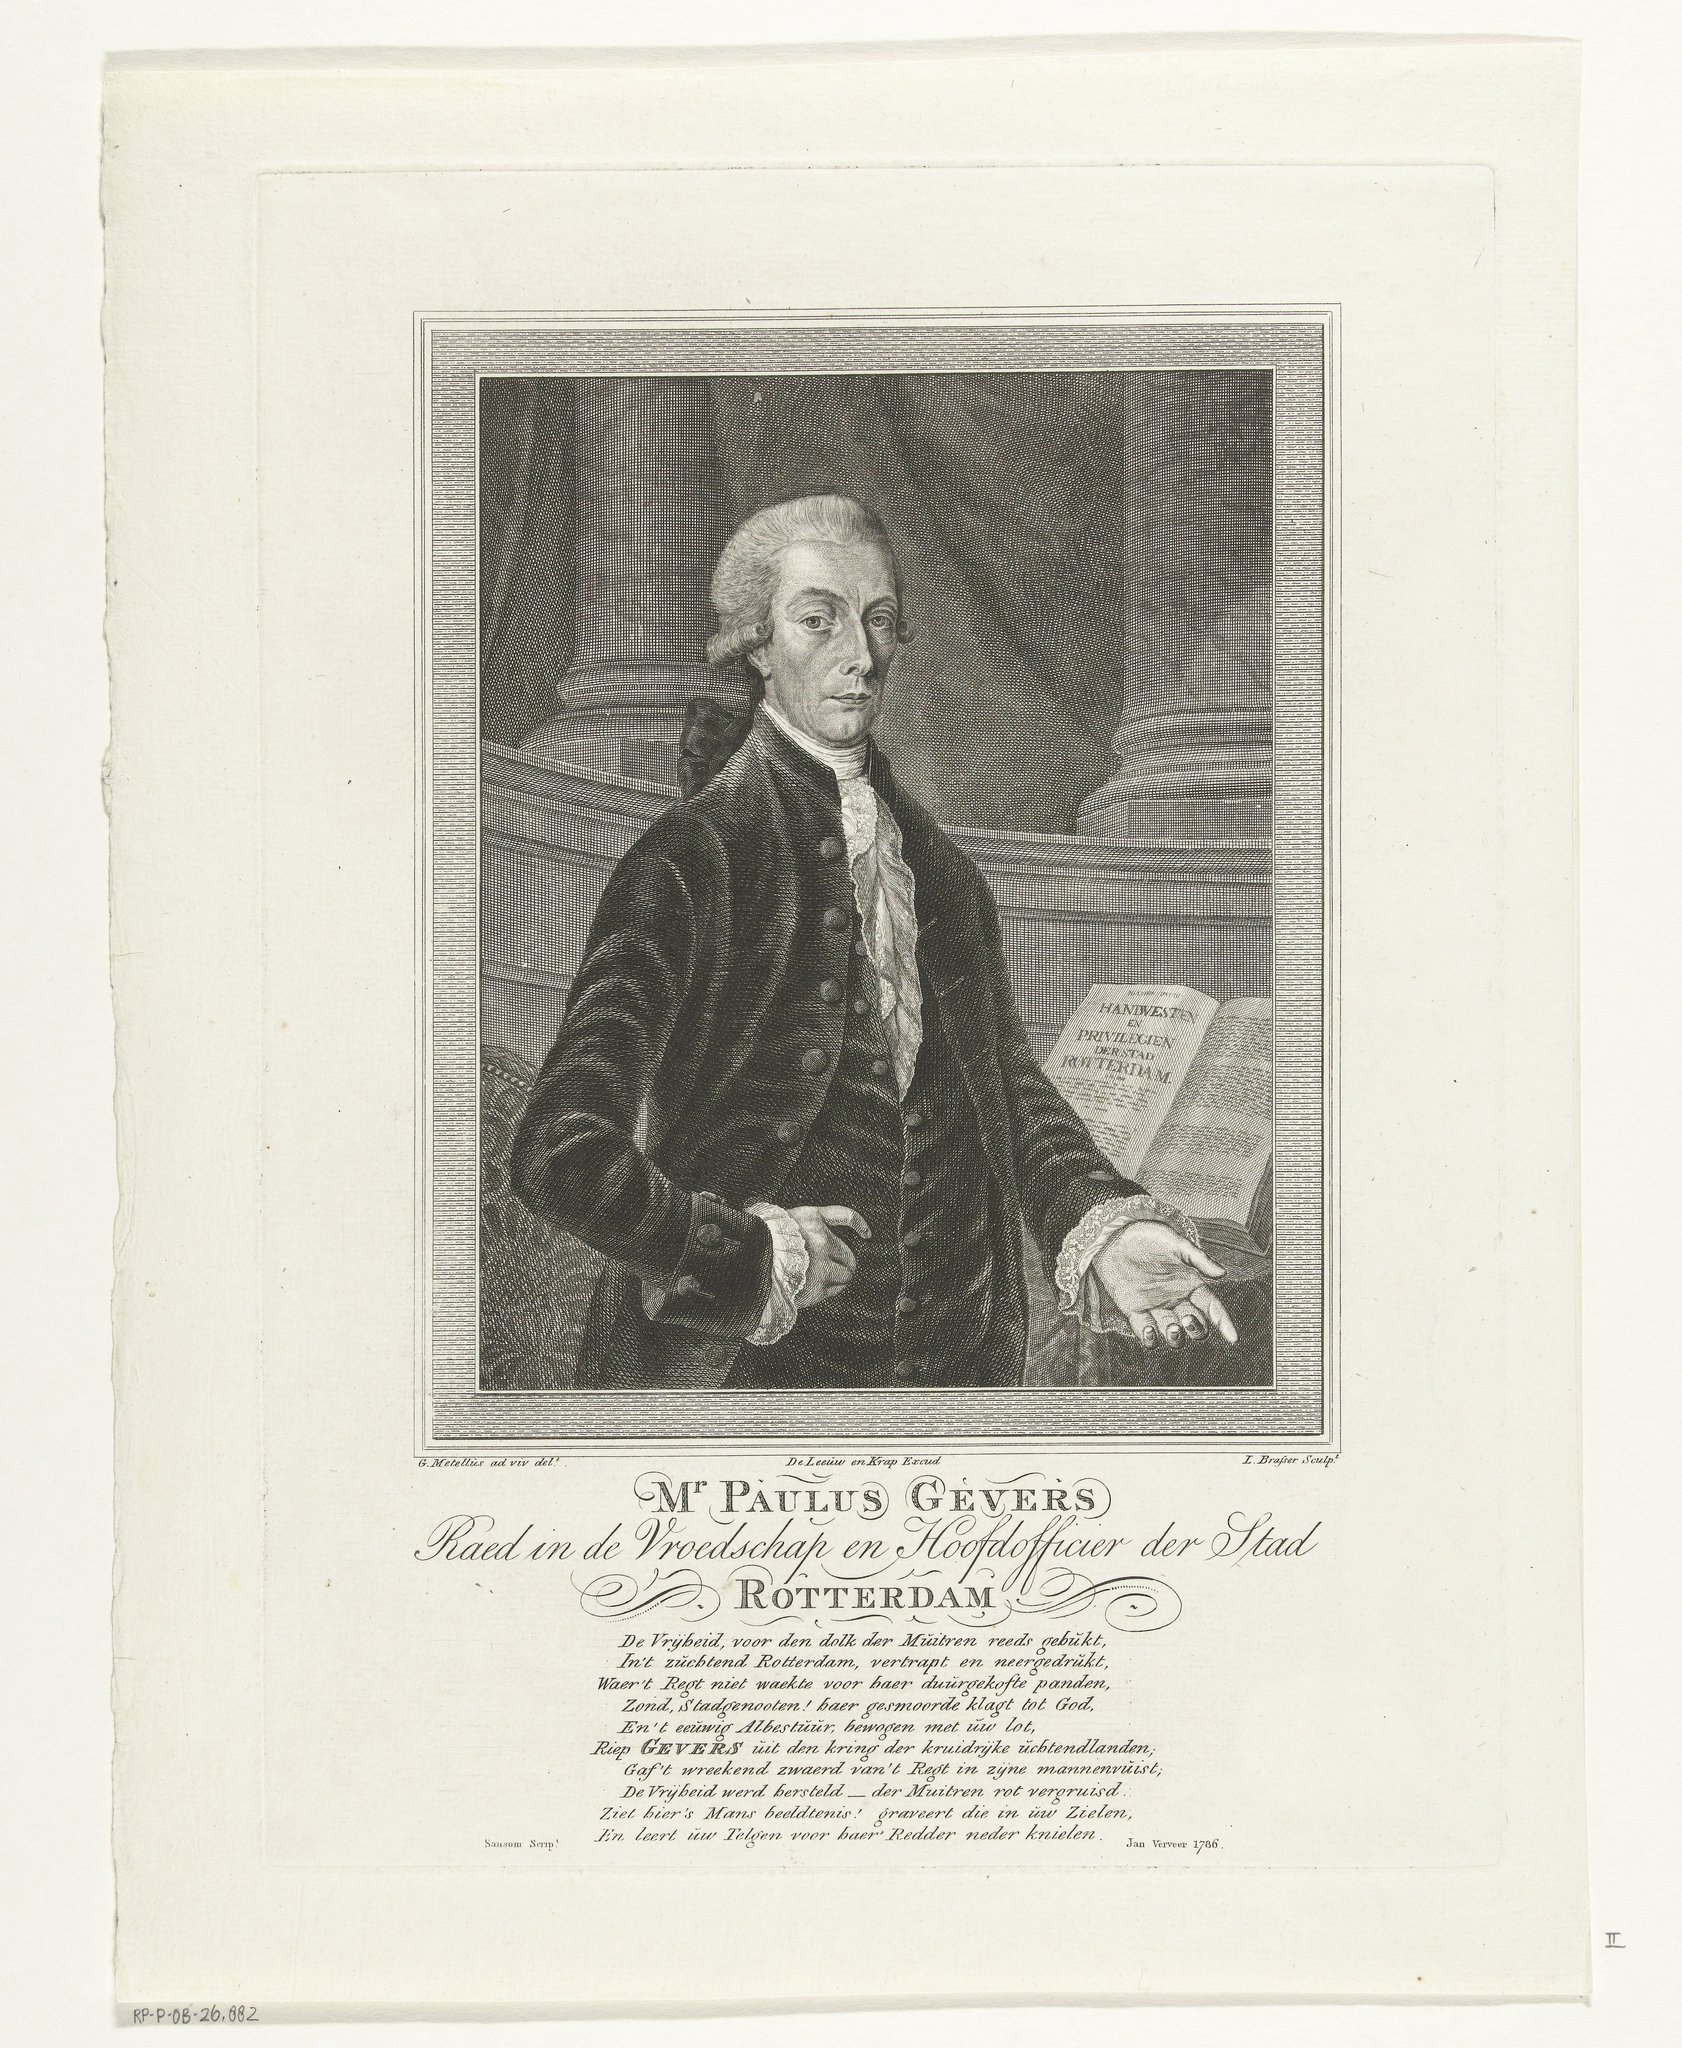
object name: print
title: Portret van Paulus Gevers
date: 1786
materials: paper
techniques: engraving, etching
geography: rotterdam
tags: rotterdam, historical persons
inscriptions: collector's mark: Lugt 2228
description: Portret van Paulus Gevers staand naast tafel met opengeslagen handboek dat verwijst naar zijn beroep als hoofdofficier van de stad Rotterdam. Onder het portret staat een tienregelig vers van Jan Verveer in het Nederlands.